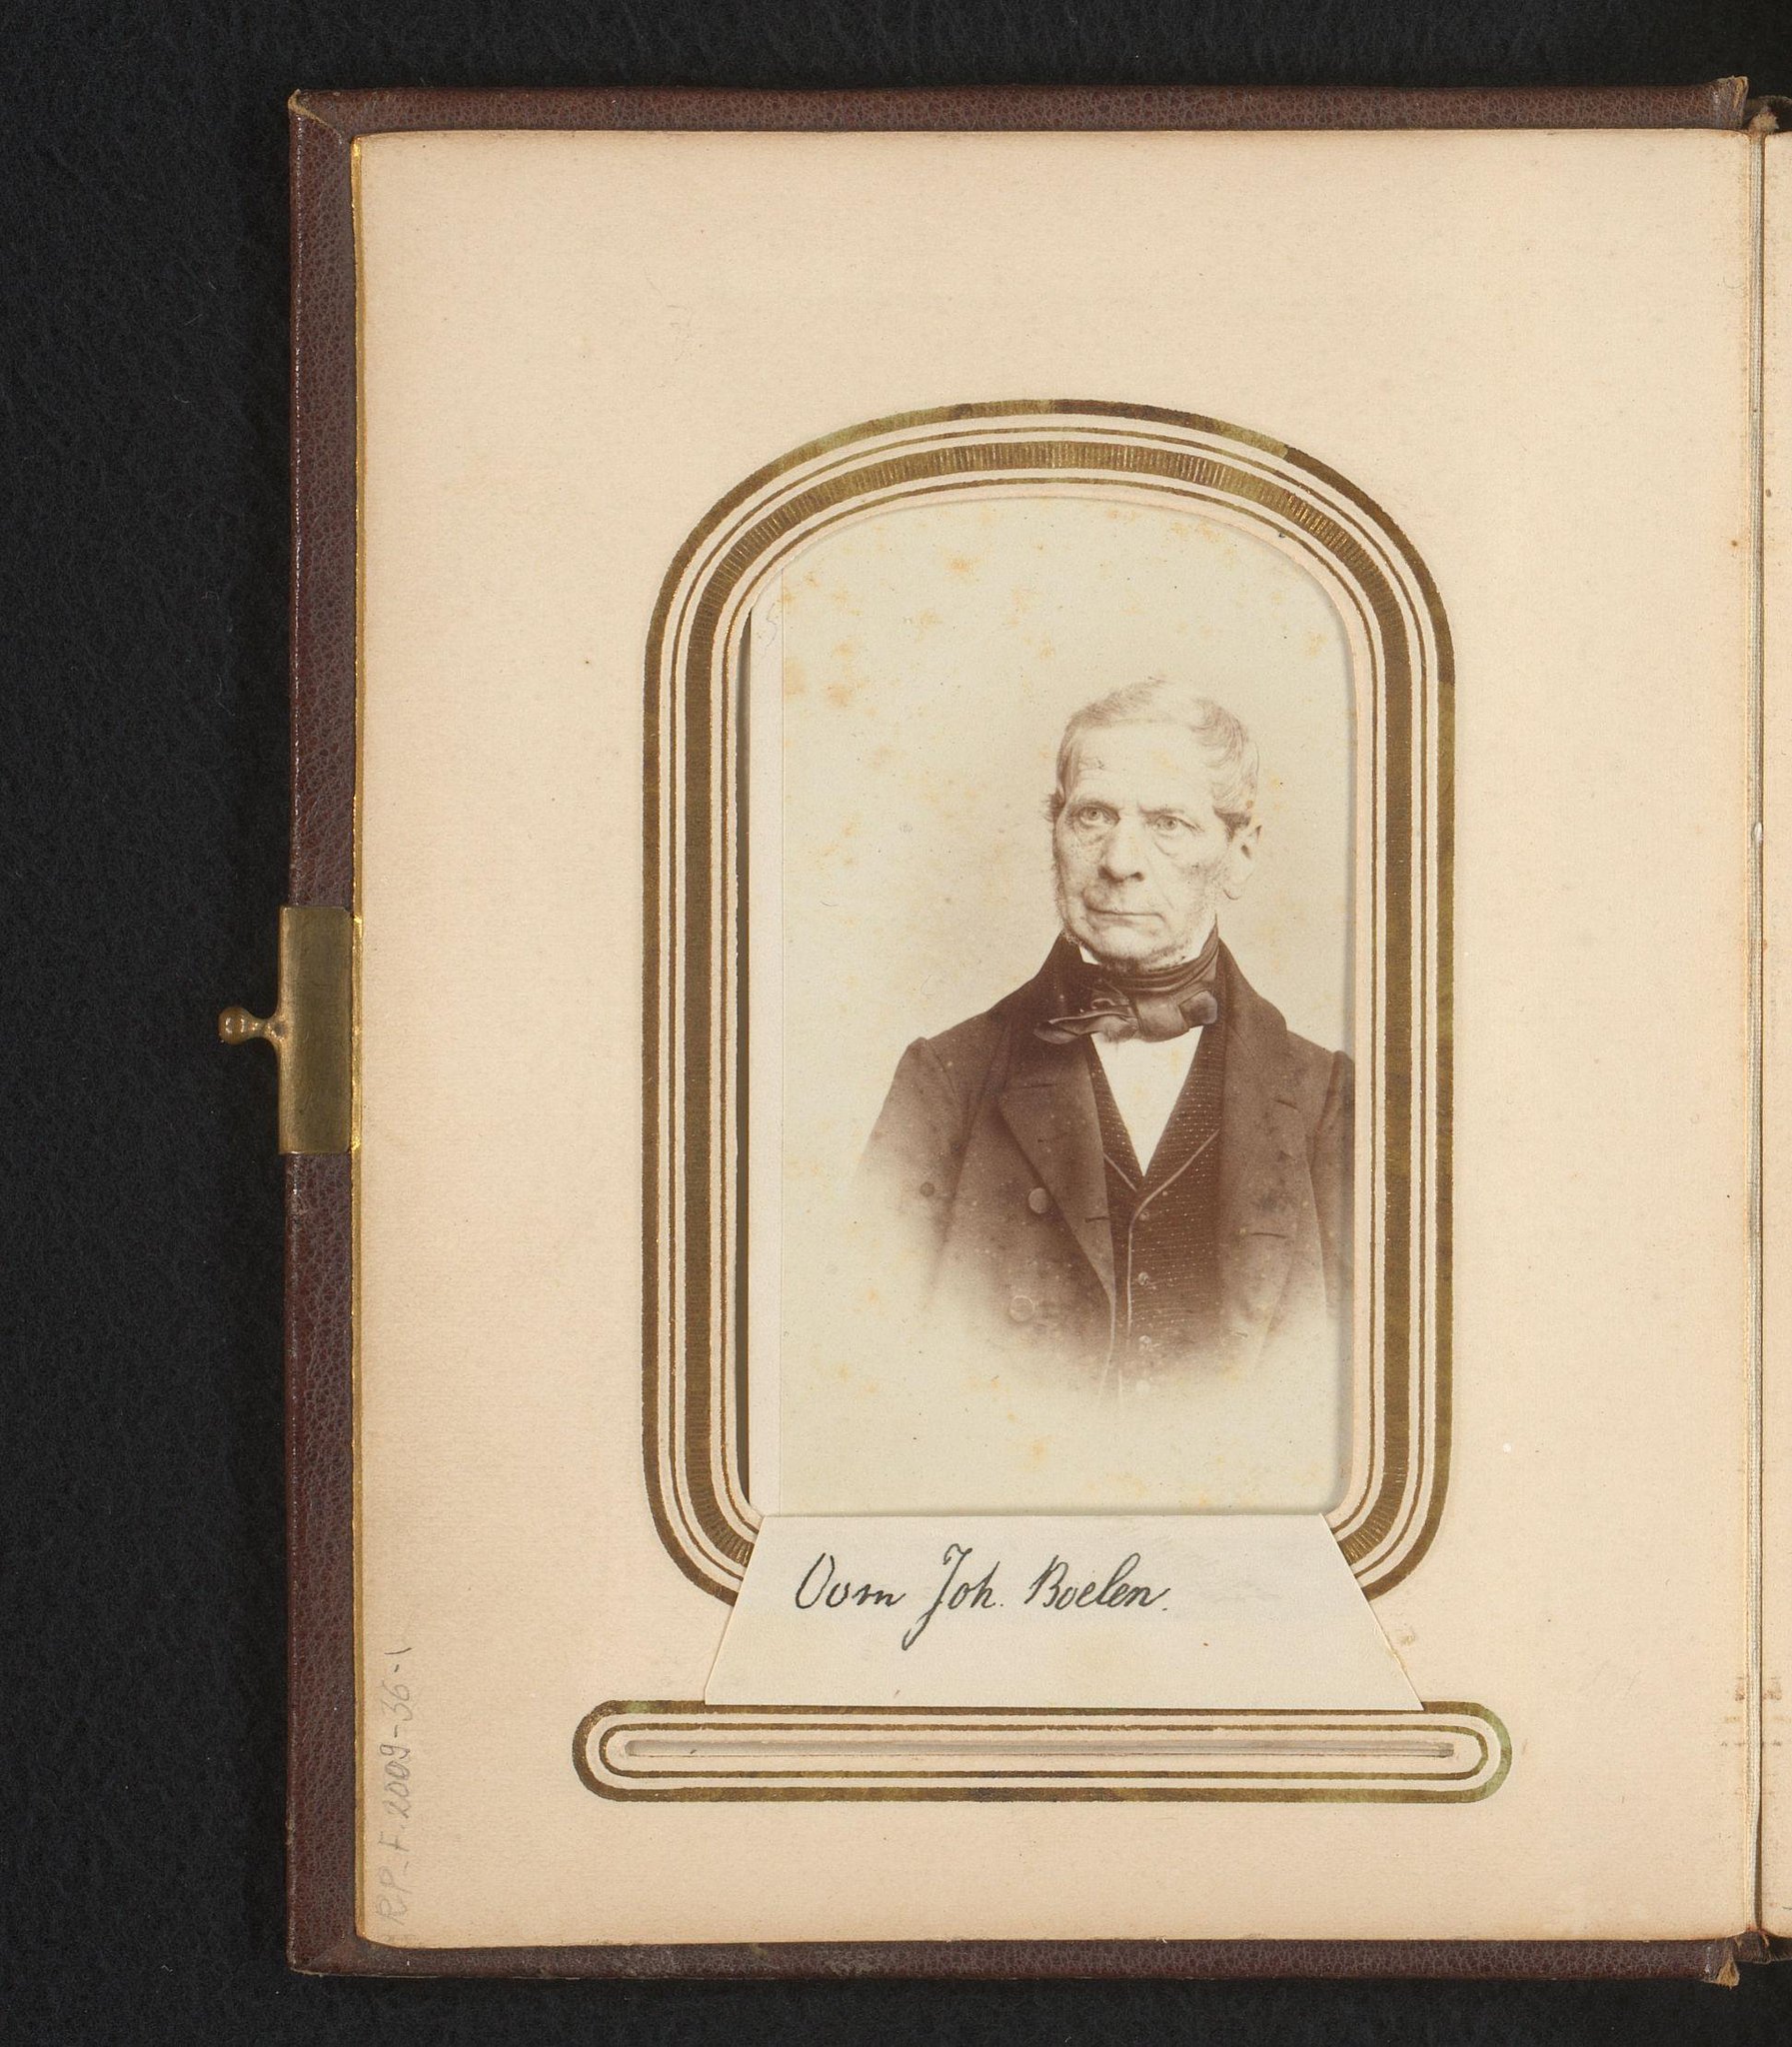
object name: carte de visite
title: Oom Joh. Boelen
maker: Anonymous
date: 1860-1870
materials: cardboard, paper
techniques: albumen print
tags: historical persons